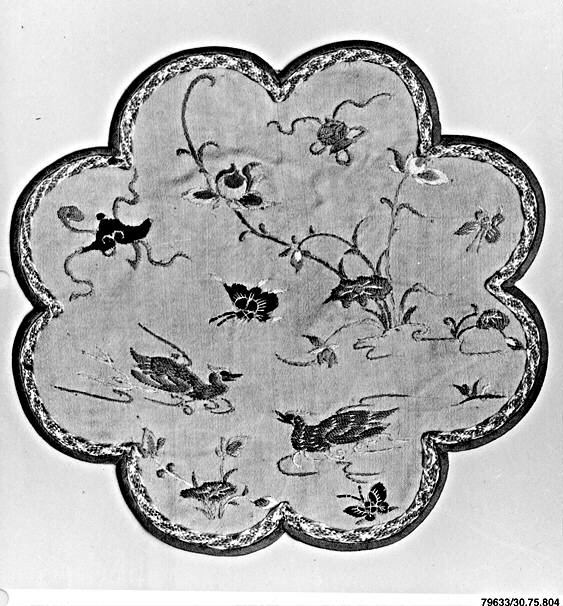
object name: medallion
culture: chinese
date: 1644-1911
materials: silk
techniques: bookbinding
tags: ducks,butterflies